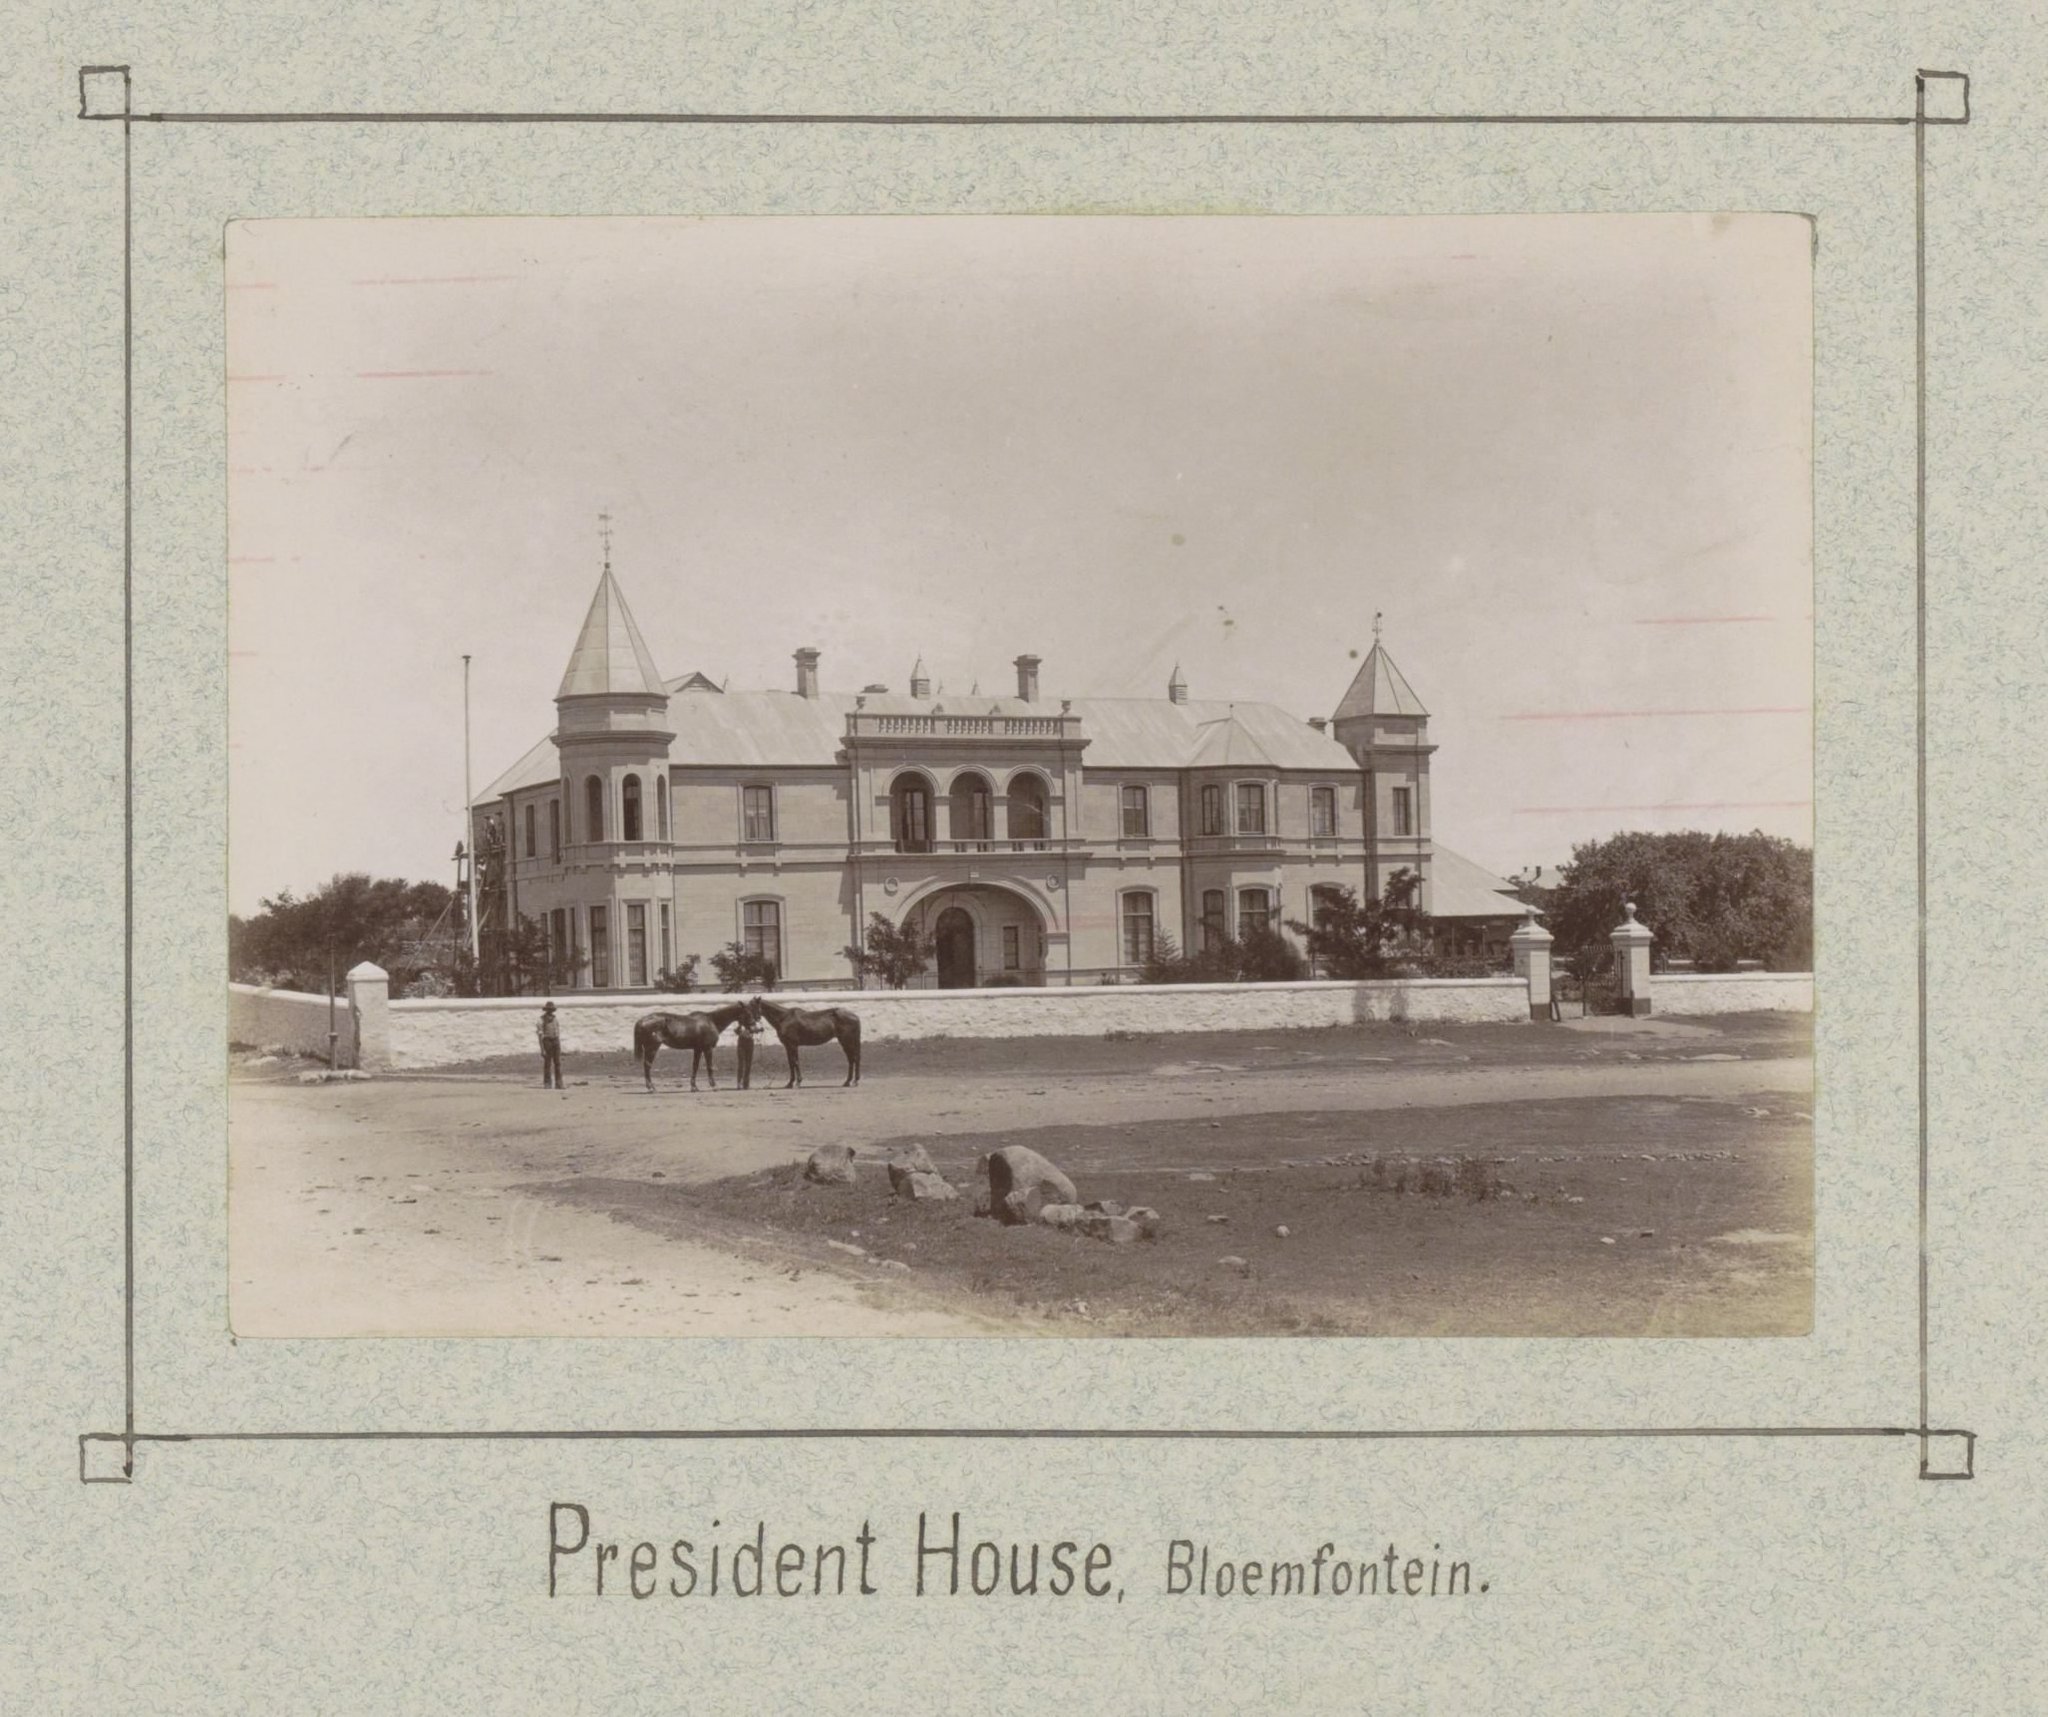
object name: photograph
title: President House, Bloemfontein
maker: Anonymous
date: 1880-1900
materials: photographic support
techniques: albumen print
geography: bloemfontein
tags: horse, façade (of house or building)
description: President House fungeerde van 1886 tot 1899 als ambtswoning voor de presidenten van Oranje Vrijstaat.